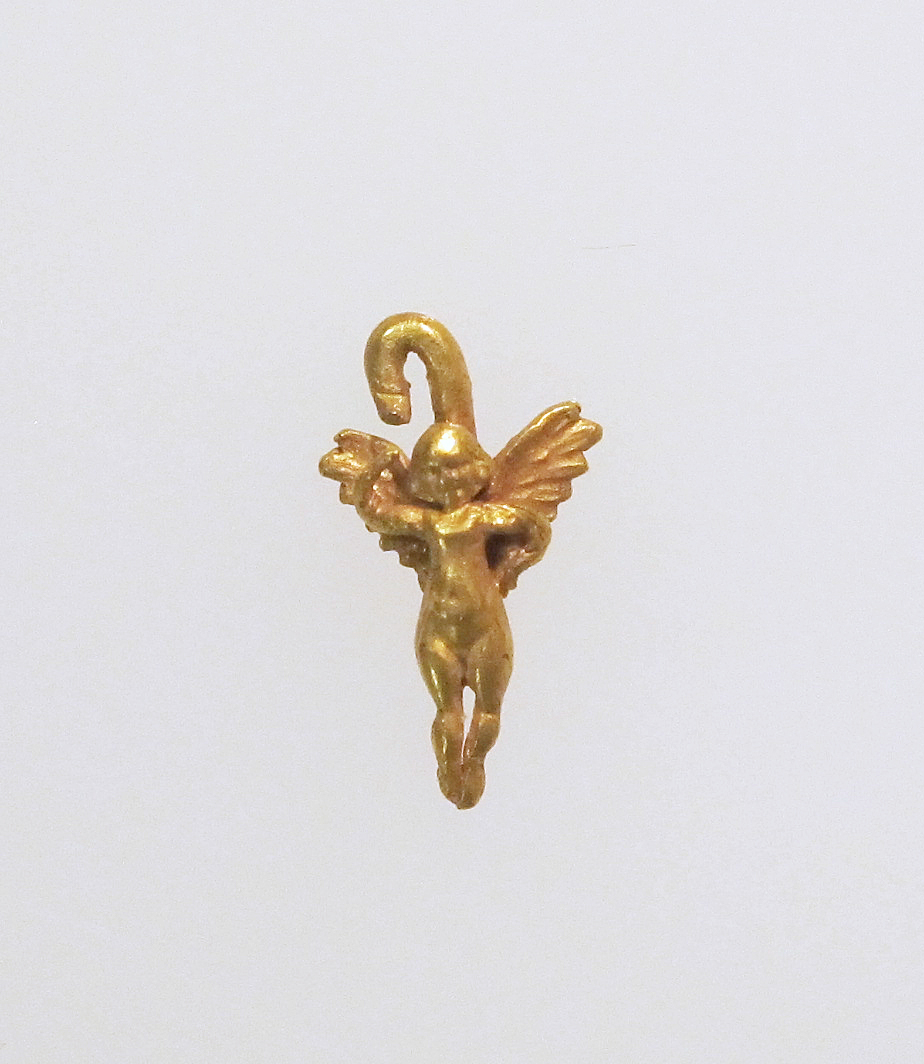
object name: pendant with eros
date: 400-301 BCE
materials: gold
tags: eros